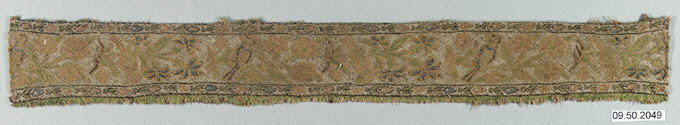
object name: textile fragment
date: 1801-1900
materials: linen, metal thread, silk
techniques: brocade, weave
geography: iran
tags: flowers